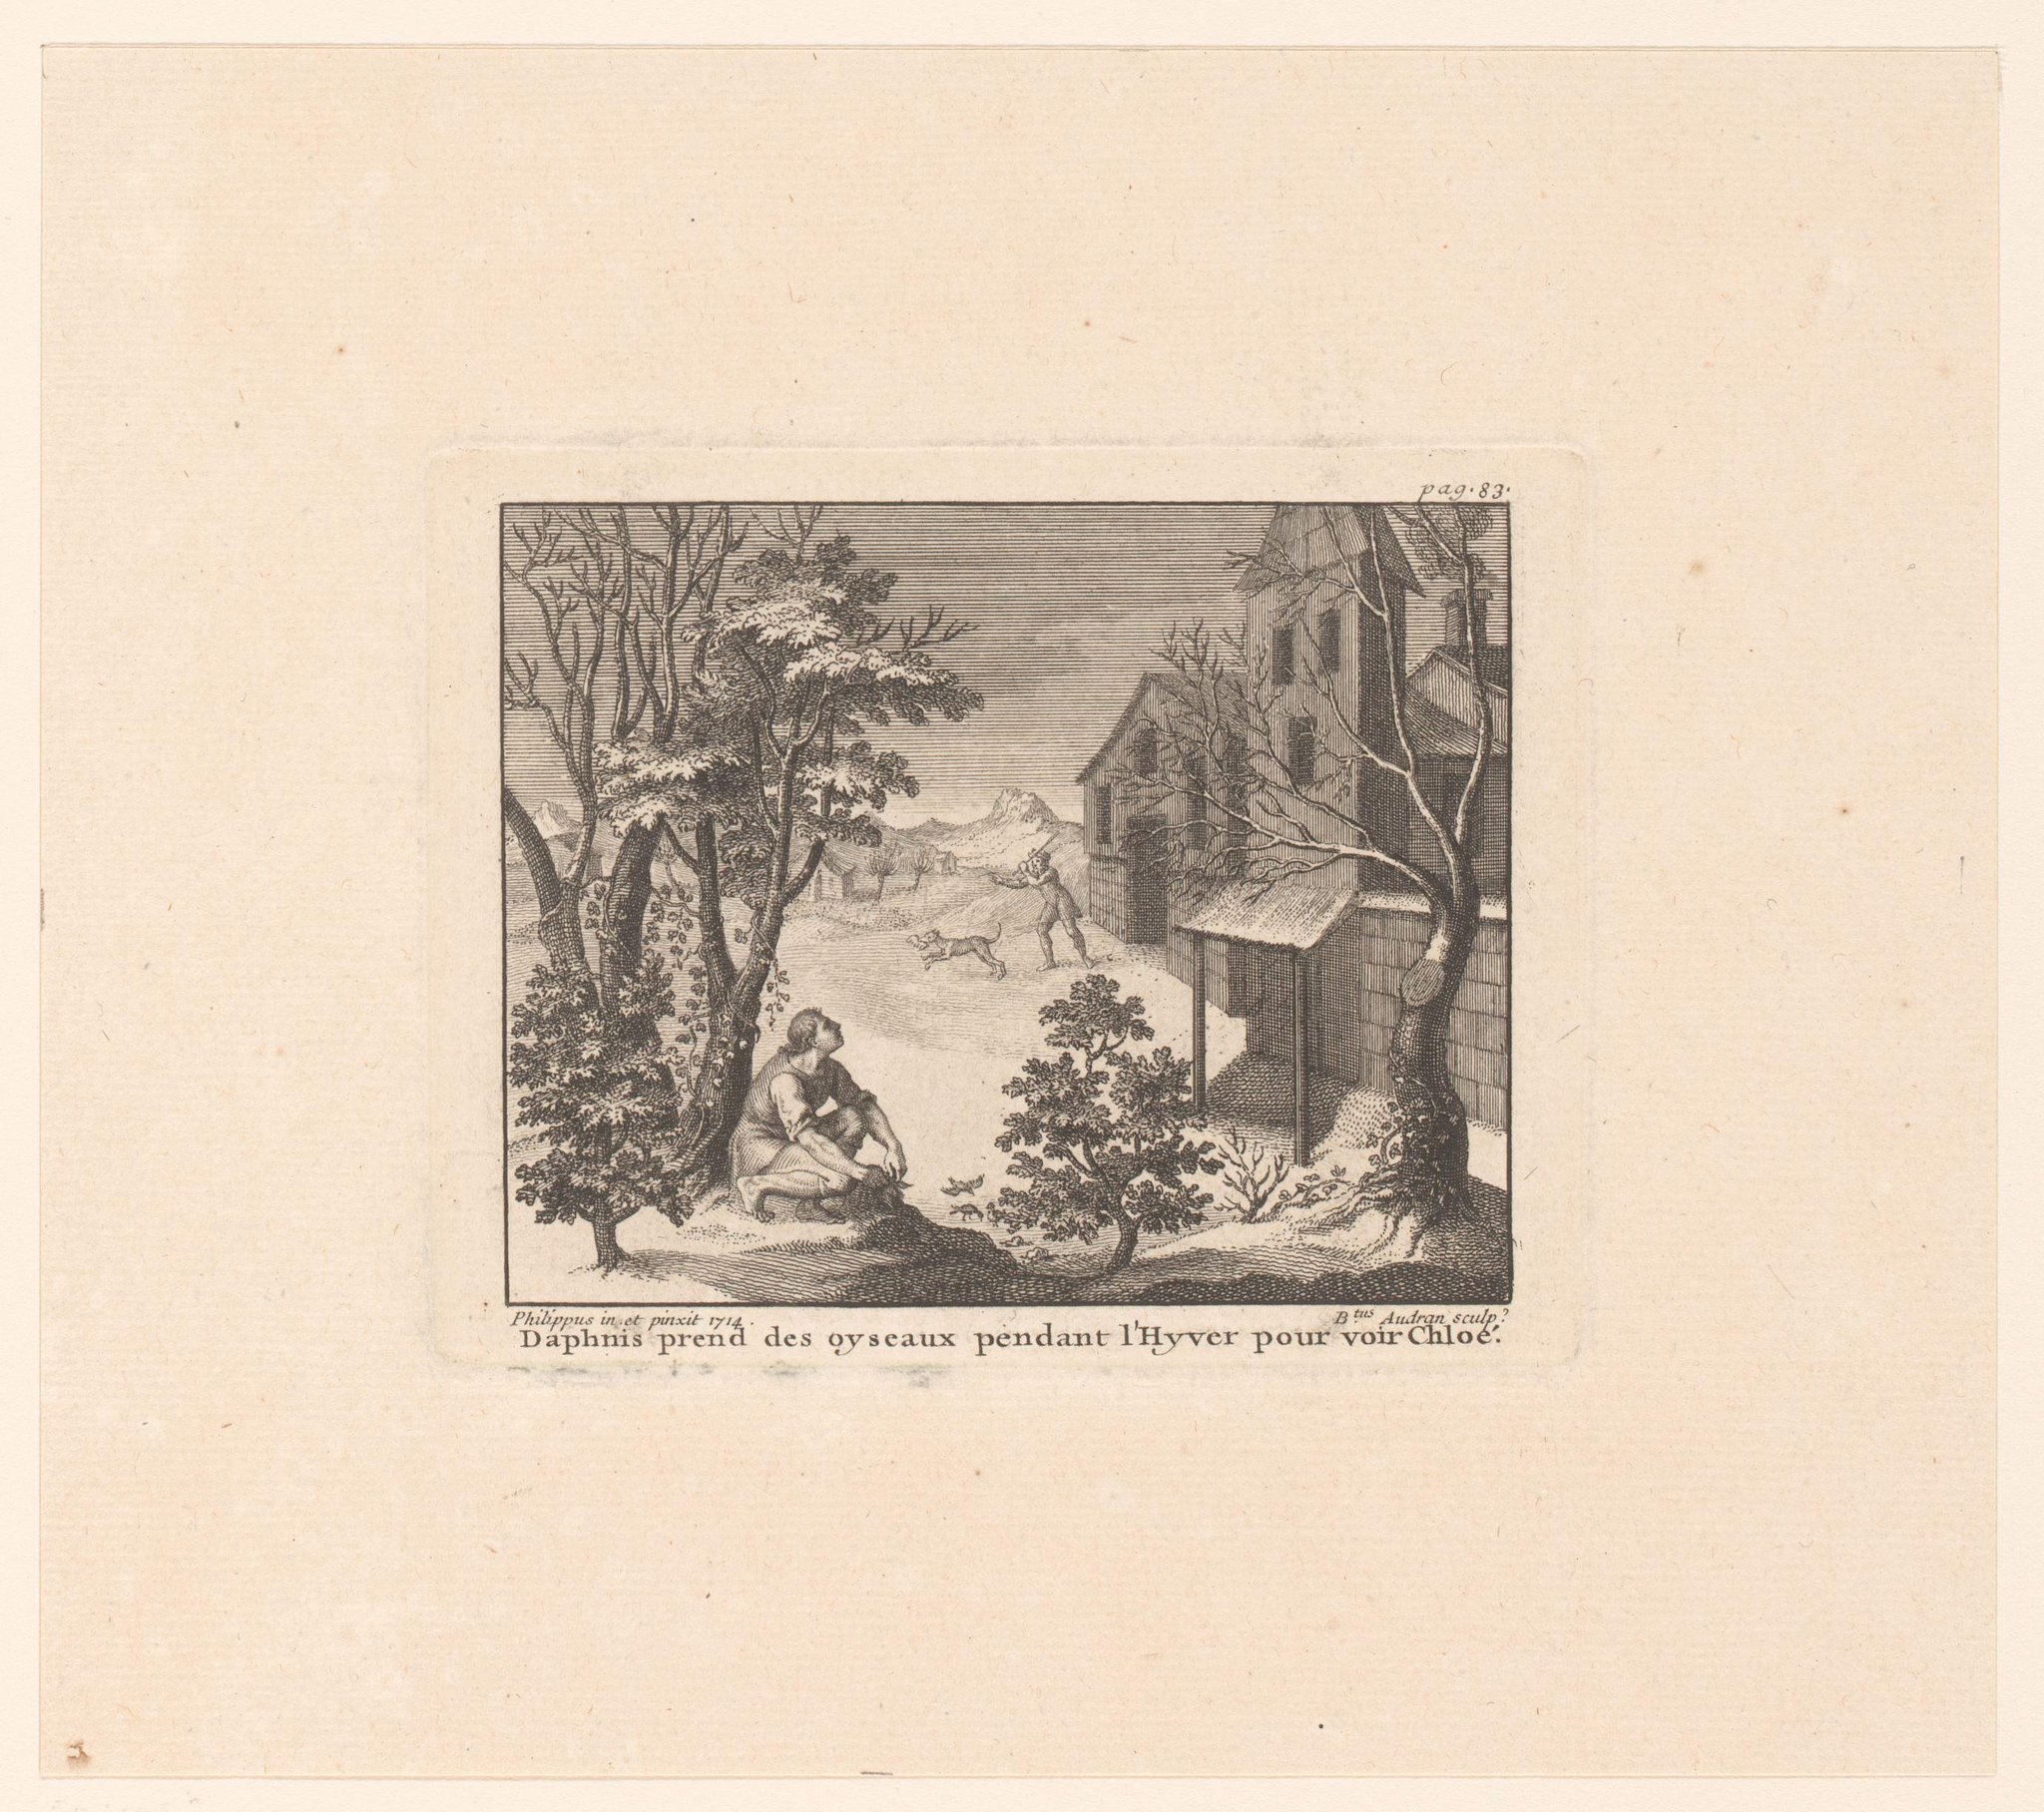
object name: book illustration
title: Daphnis op vogeljacht in de winter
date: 1718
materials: paper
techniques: etching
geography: paris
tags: bird hunting, winter landscape; landscape symbolizing winter (the four seasons of the year), daphnis (in greek mythology a shepherd who invented pastoral poetry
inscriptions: collector's mark: Lugt 2228, collector's mark: Lugt 2760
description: Prent uit: Longus. Les amours pastorales de Daphnis et de Chloé, avec figures. Parijs: s.n., 1718.